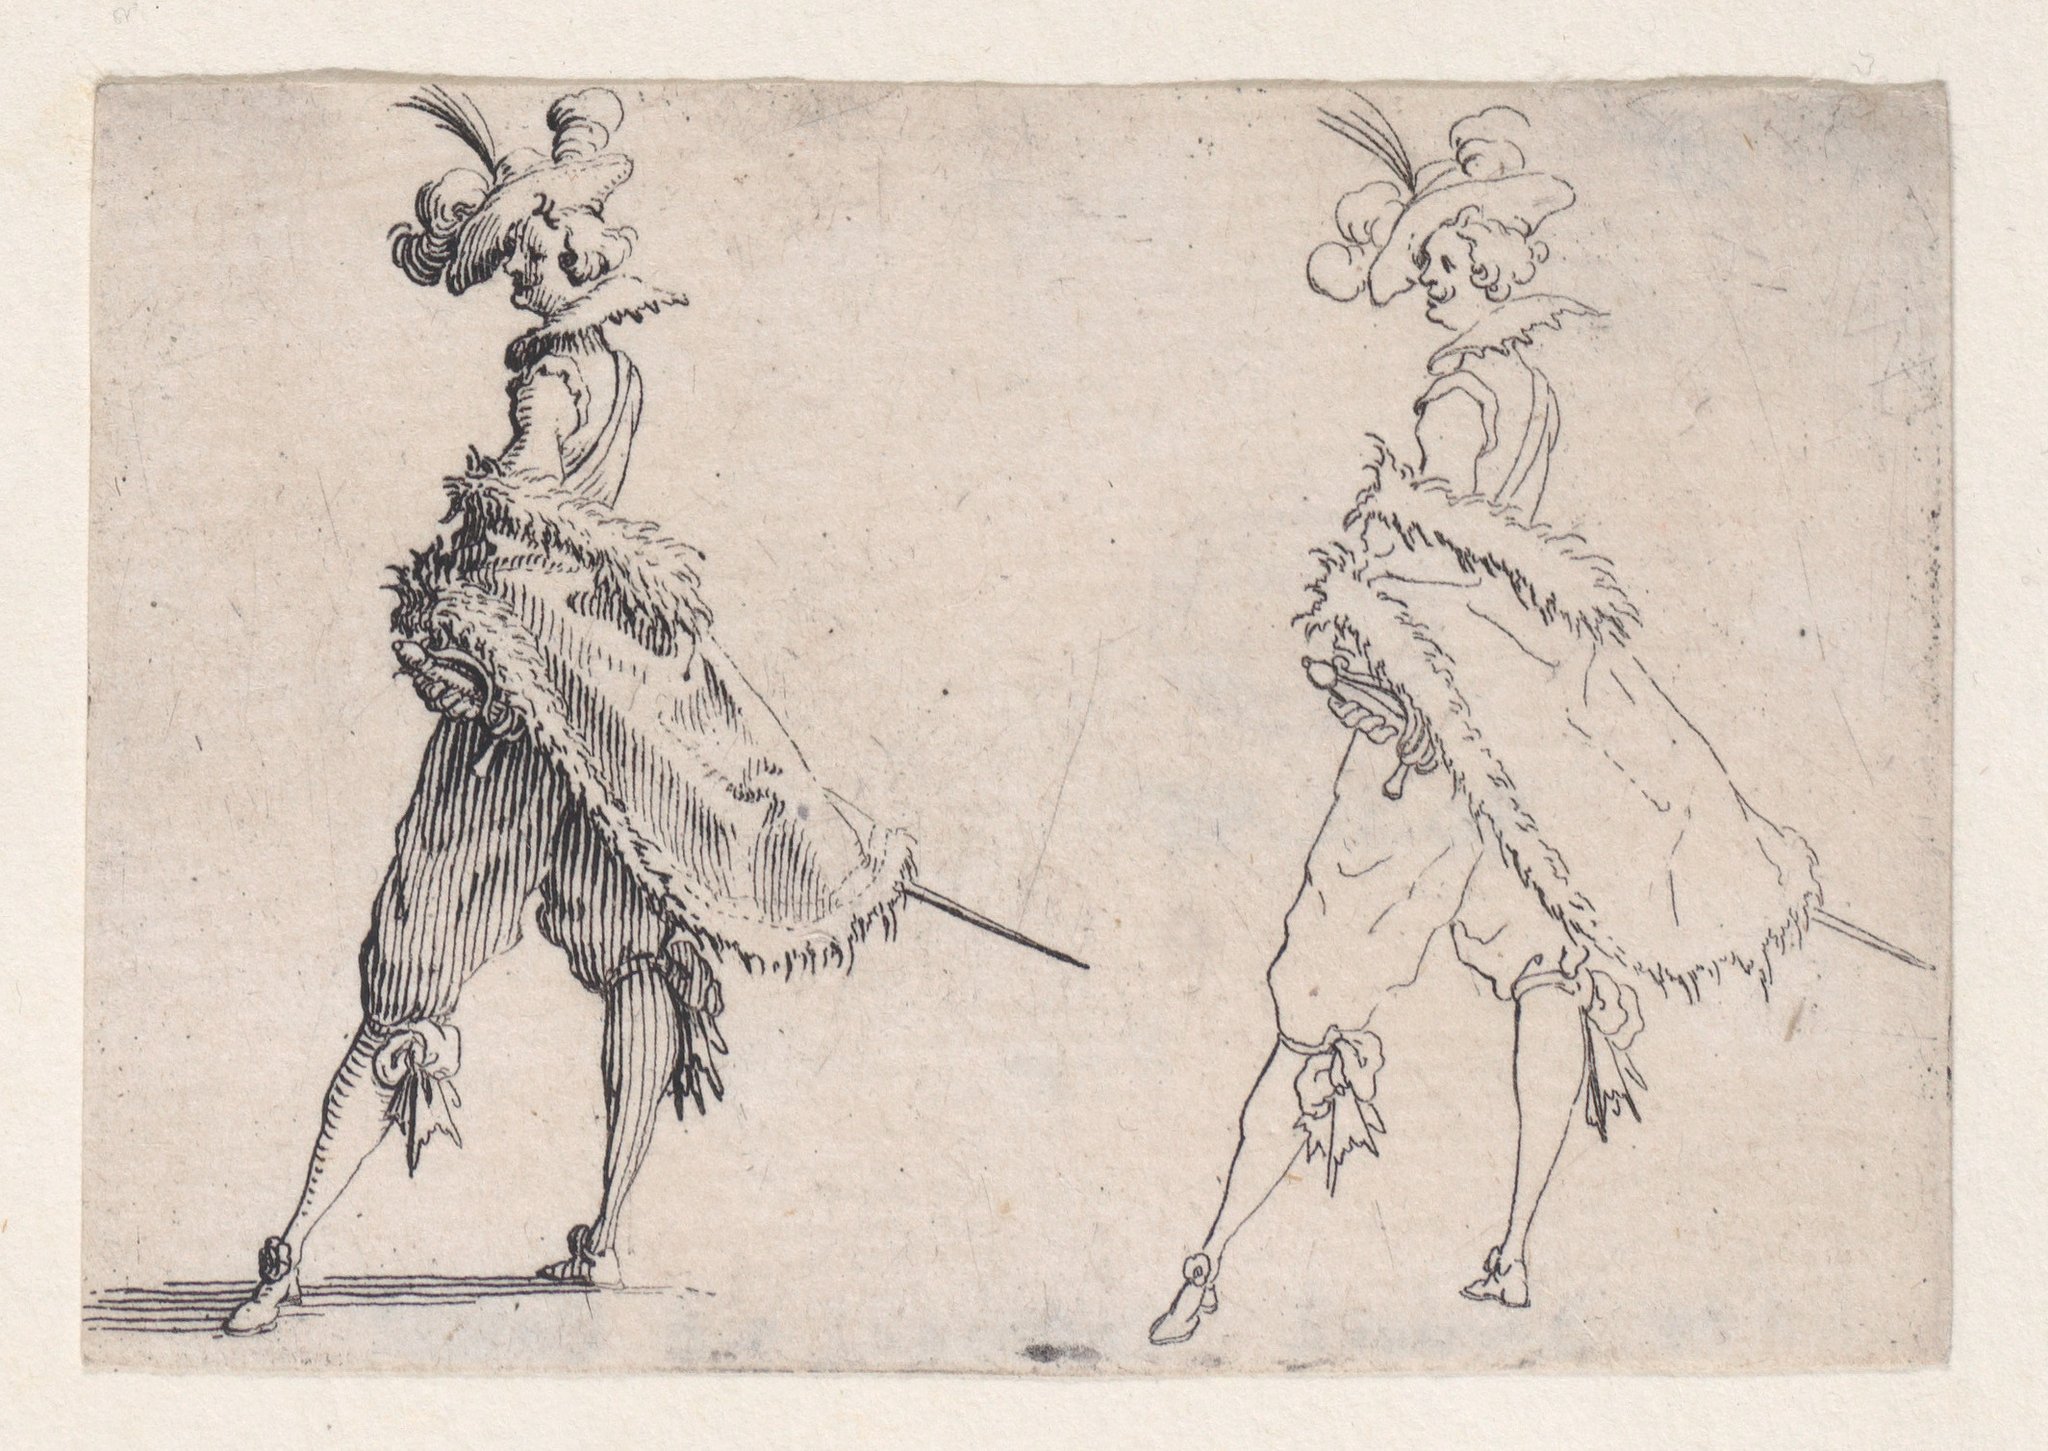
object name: print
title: Le Gentilhomme au Manteau Posé sur la Hanche (Gentleman with his Mantle on his Hip), from "Les Caprices" Series A, The Florence Set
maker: jacques callot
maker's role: artist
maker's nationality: french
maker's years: 1592-1635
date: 1617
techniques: etching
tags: men